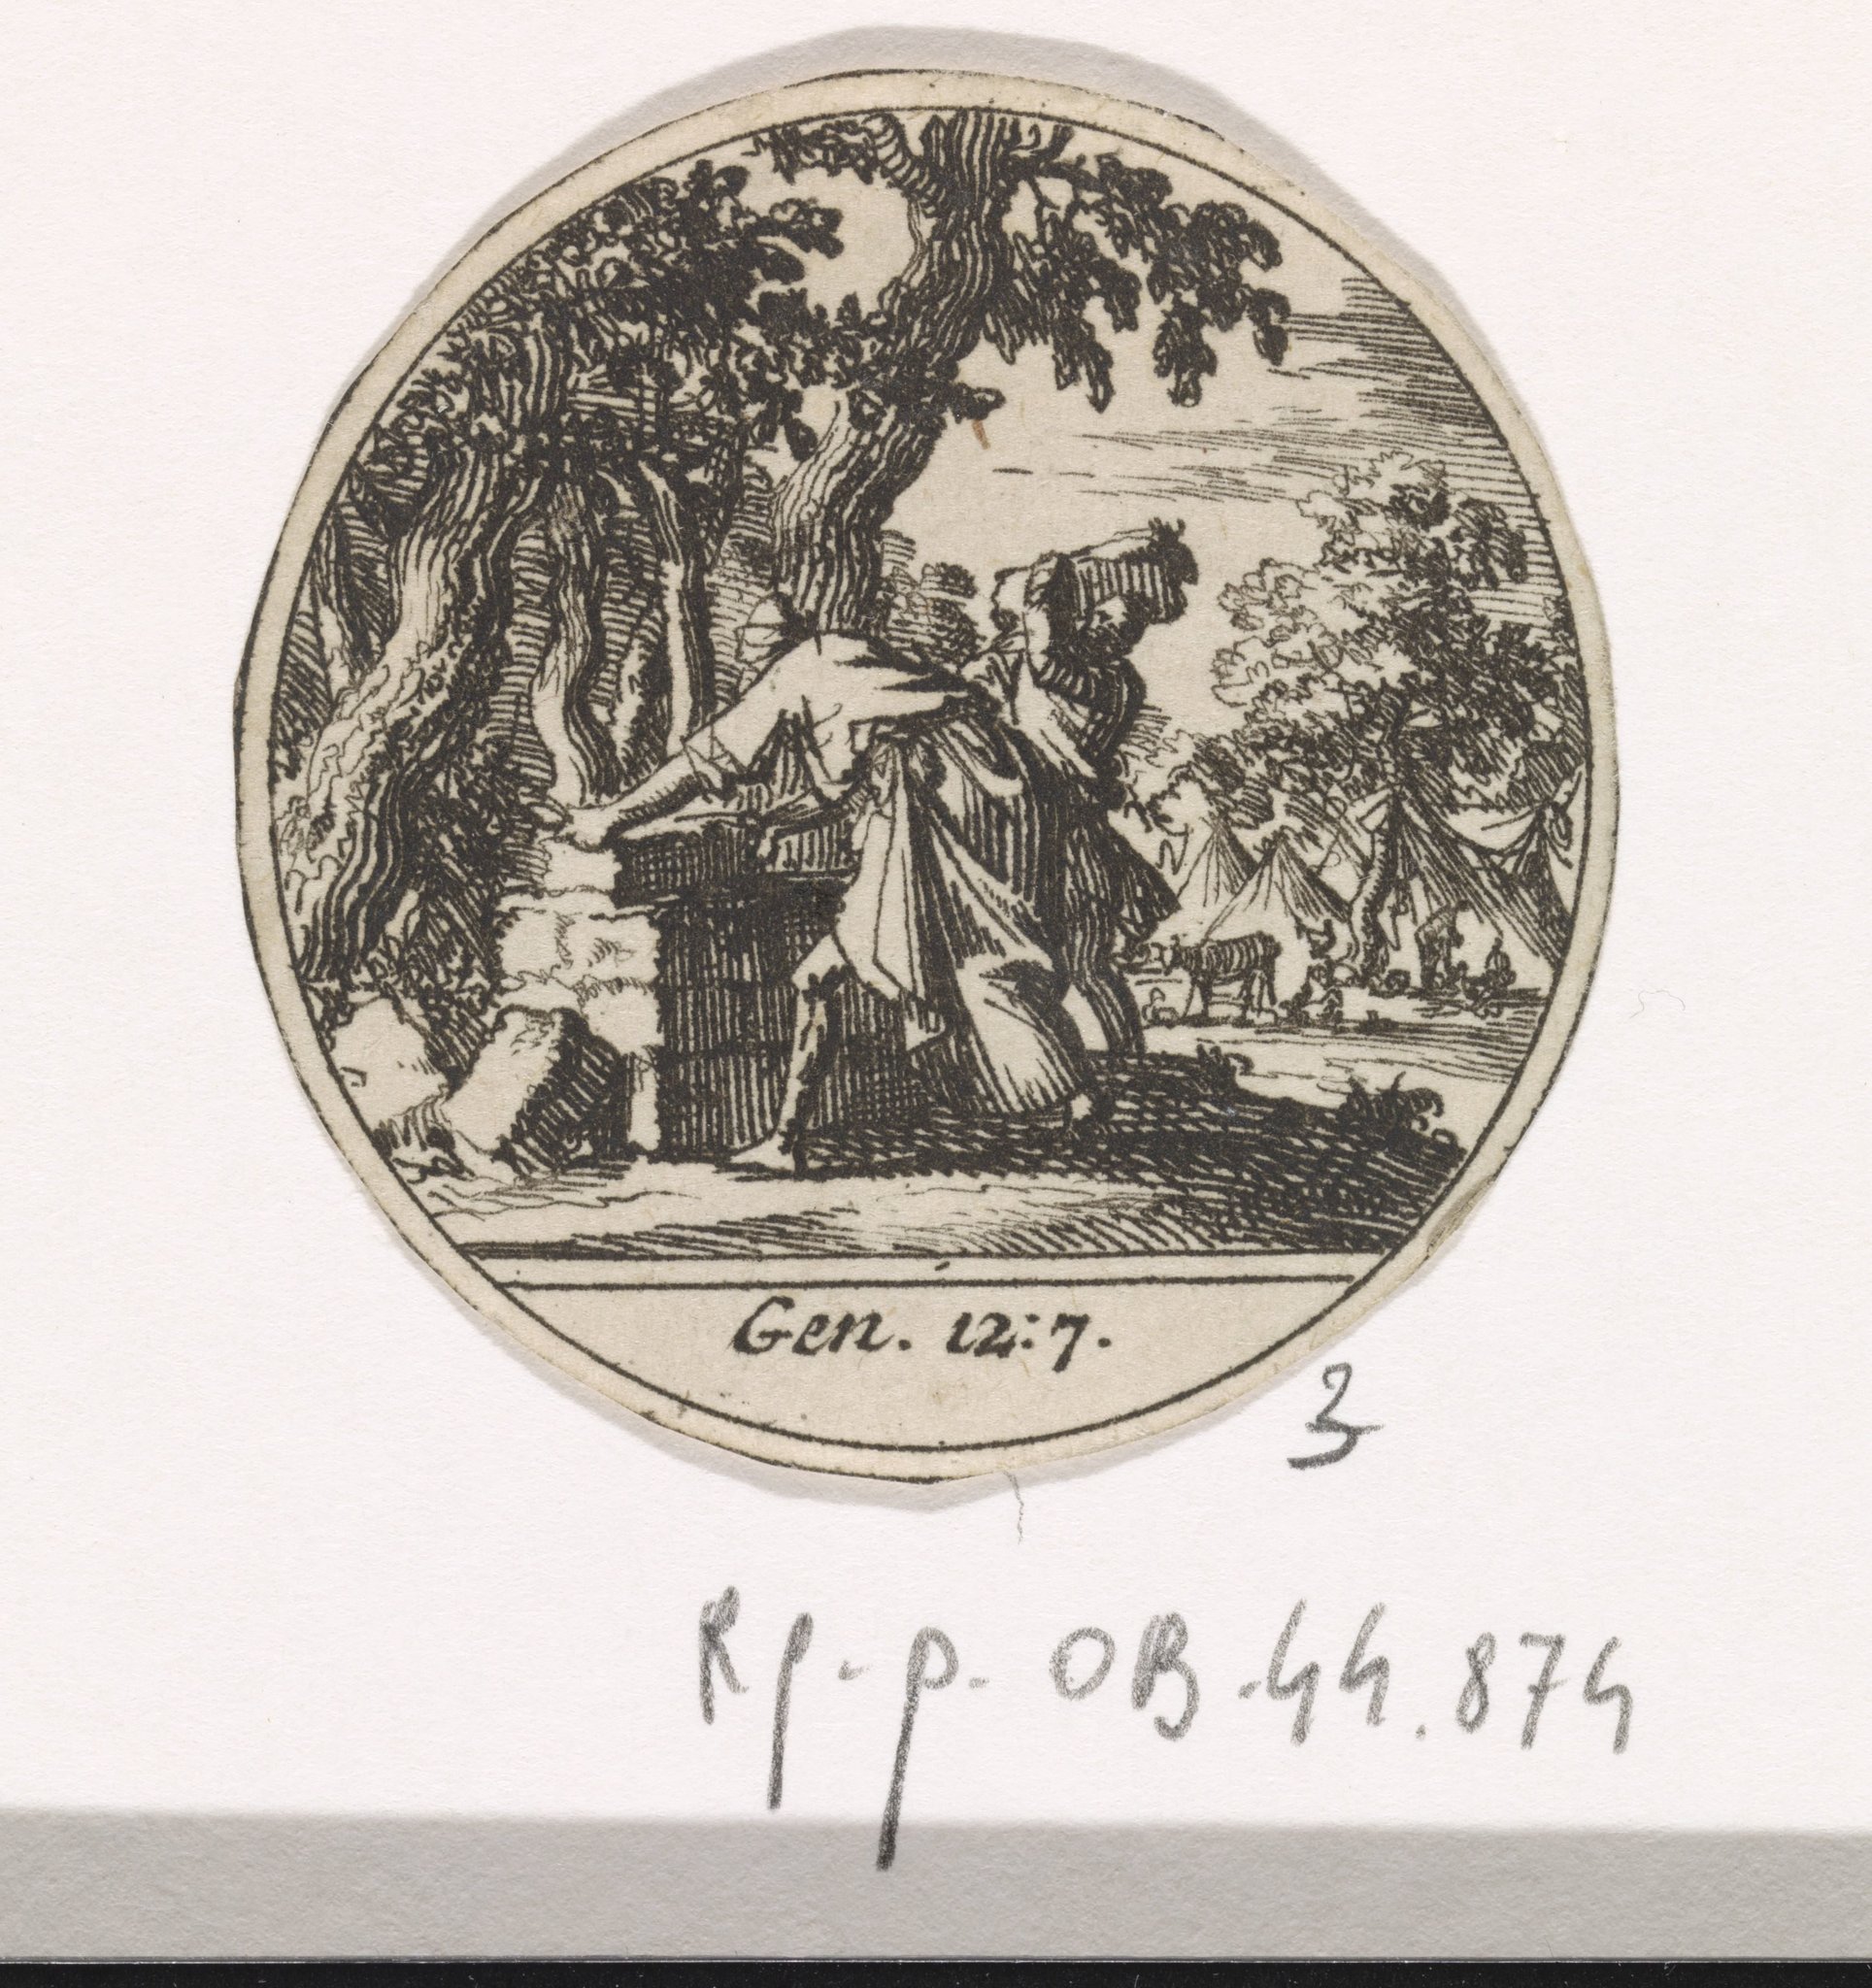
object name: print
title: Abraham bouwt een altaar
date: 1700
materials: paper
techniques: etching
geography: amsterdam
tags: abraham comes to the sacred tree of moreh at shechem, and builds his first altar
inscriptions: collector's mark: Lugt 240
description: Boekillustratie voor Willem Goeree. Mosaize historie der Hebreeuwse kerke. Amsterdam: Willem & David Goeree, 1700.